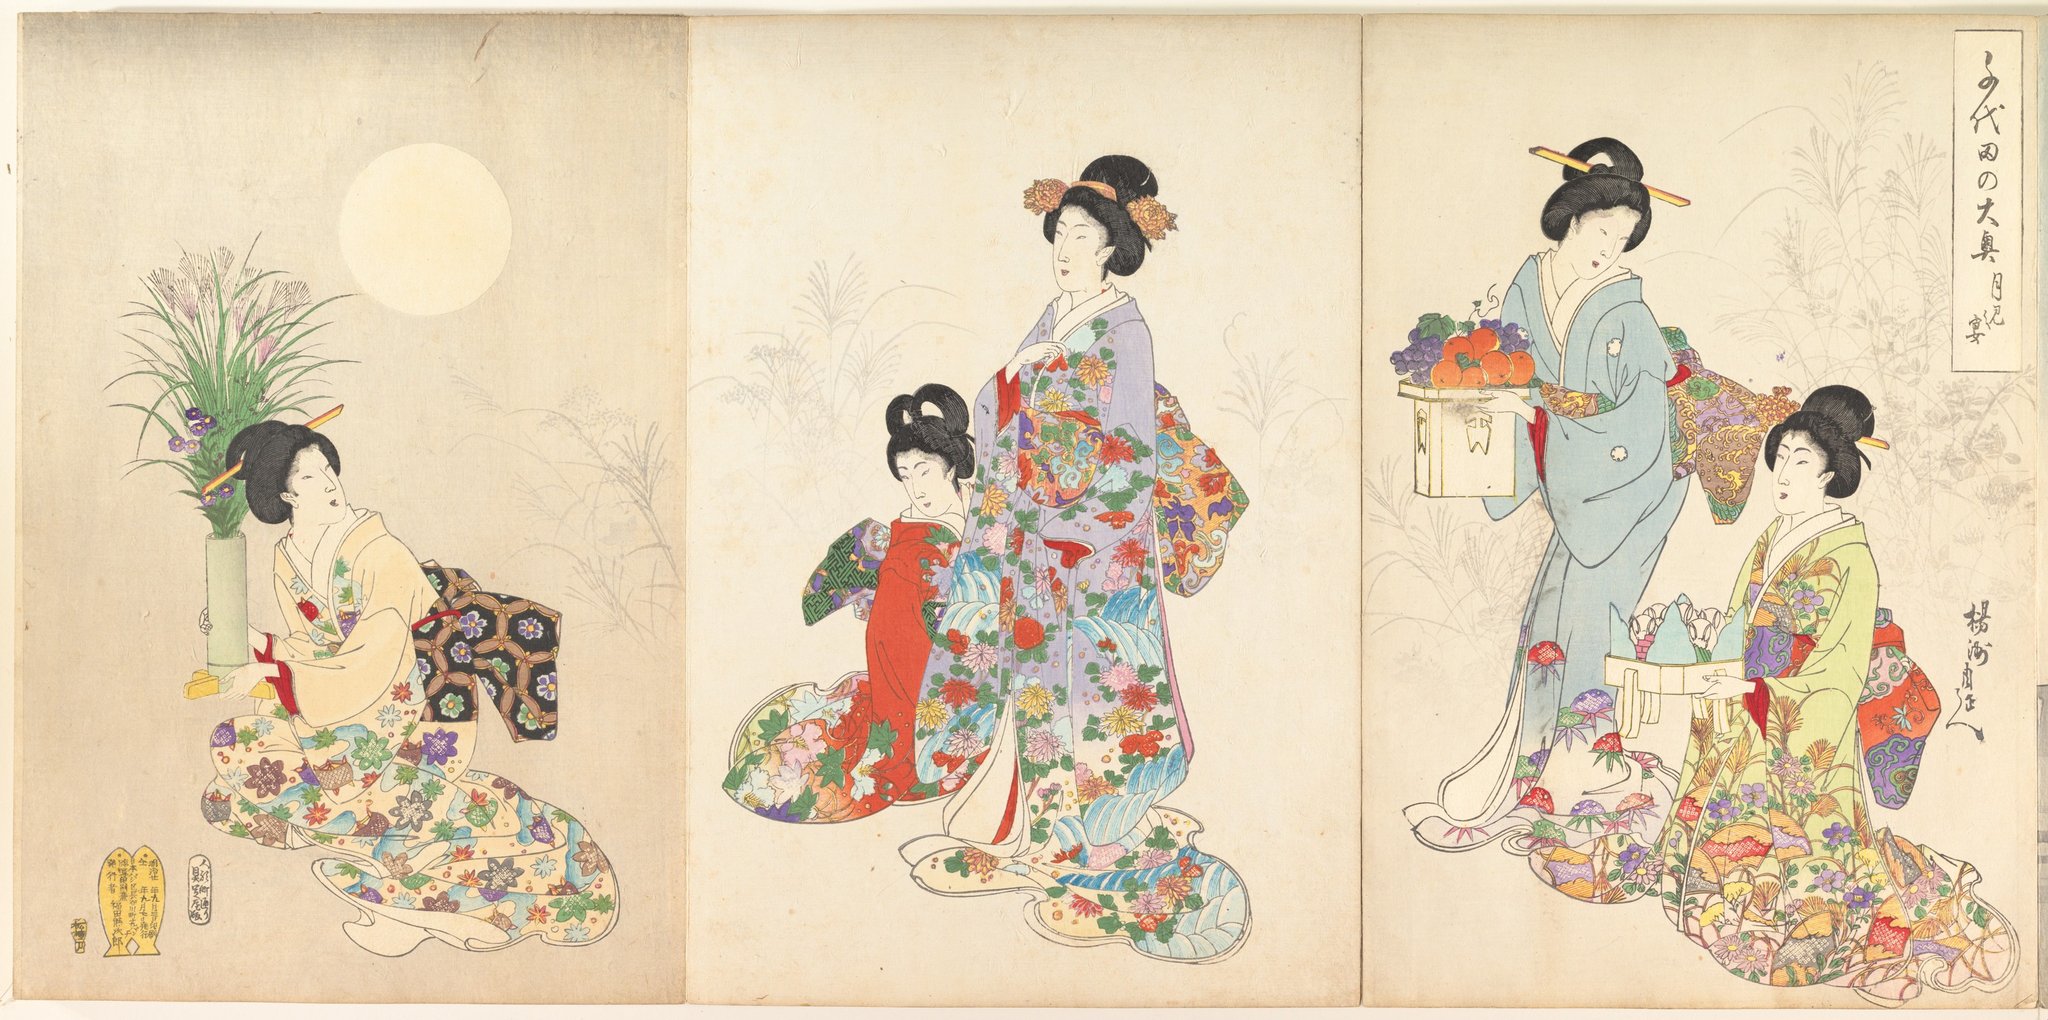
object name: print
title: Chiyoda Castle (Album of Women)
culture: japanese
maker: yōshū (hashimoto) chikanobu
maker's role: artist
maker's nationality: japanese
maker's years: 1838-1912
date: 1895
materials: ink, paper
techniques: woodblock print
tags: women,flowers